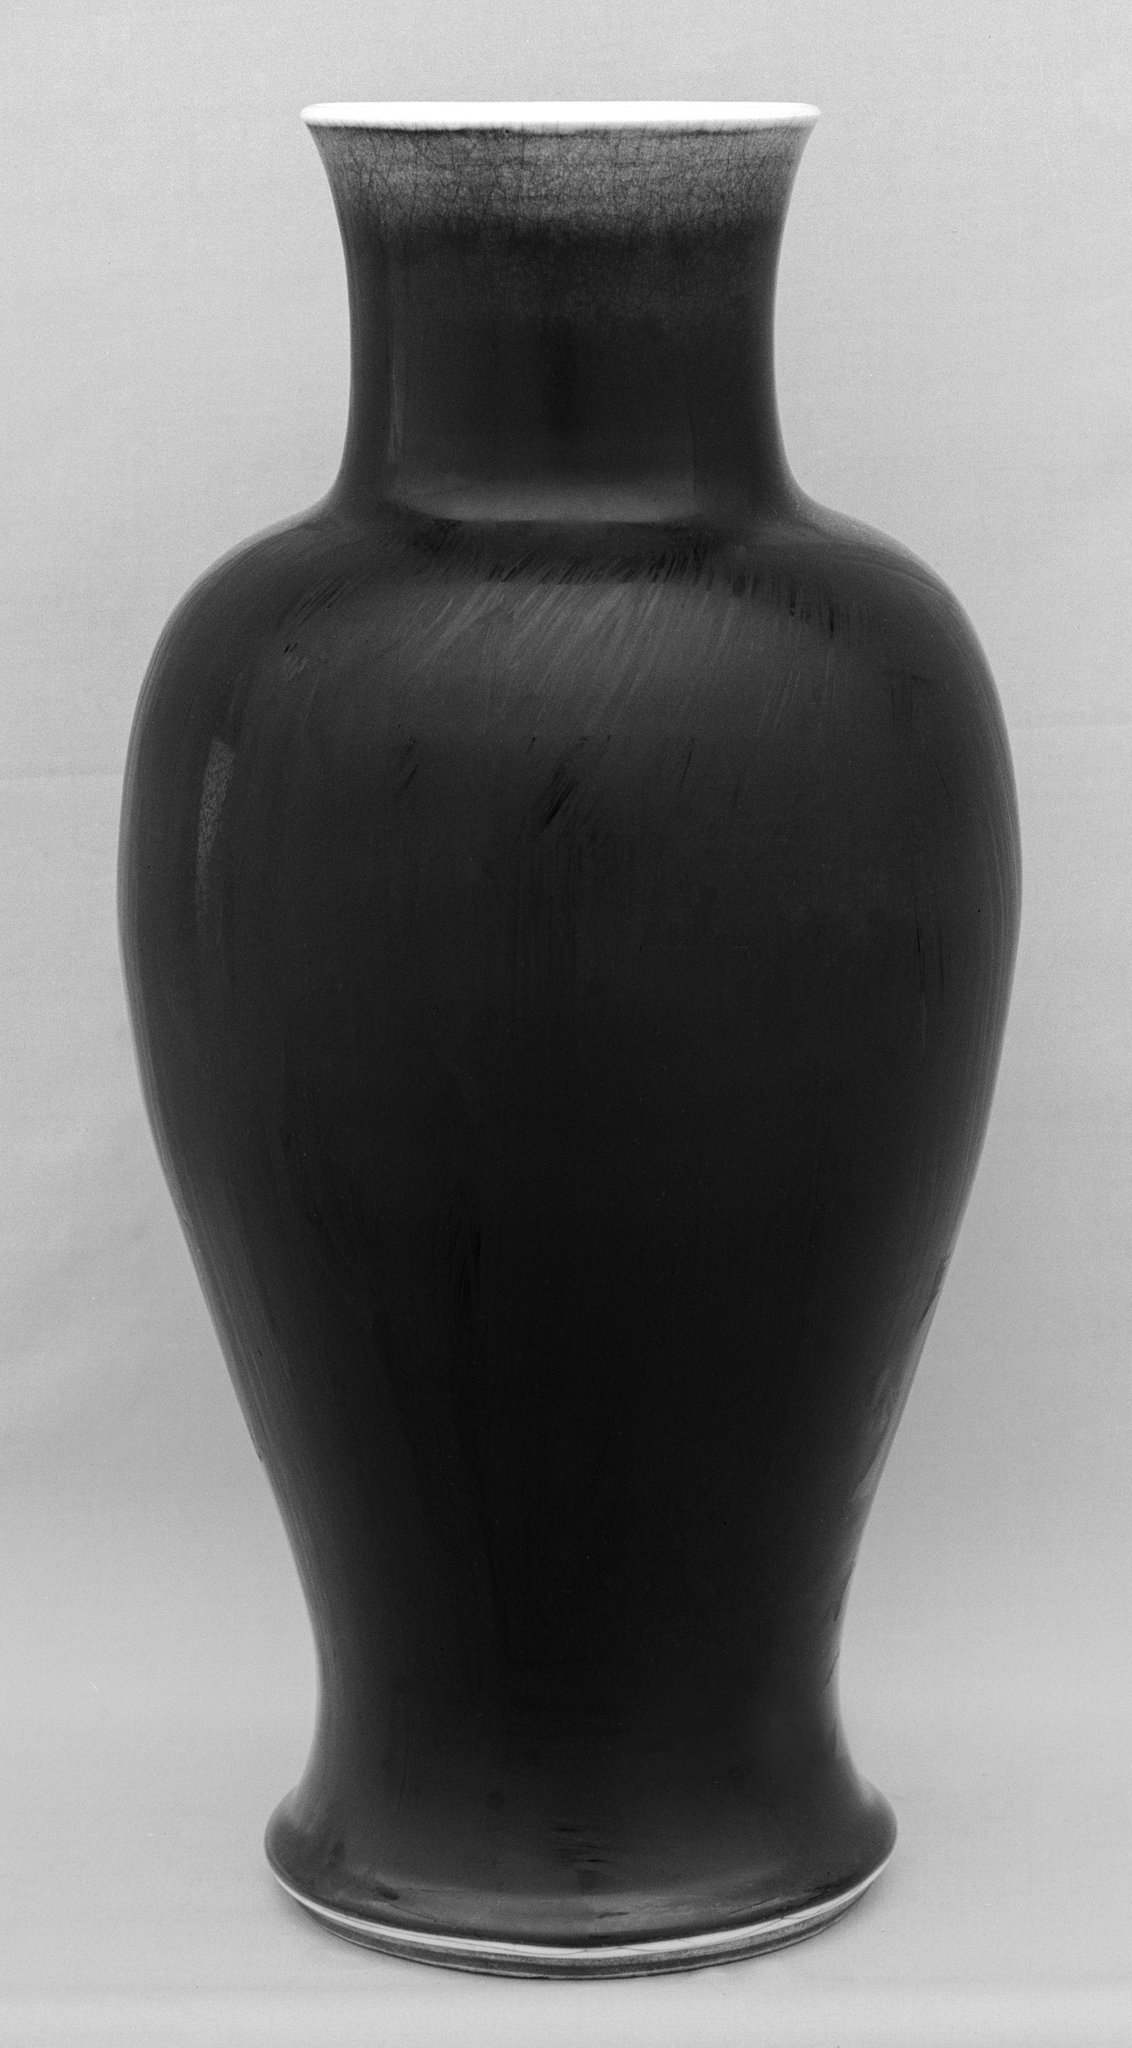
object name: vase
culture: chinese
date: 1662-1722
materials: porcelain